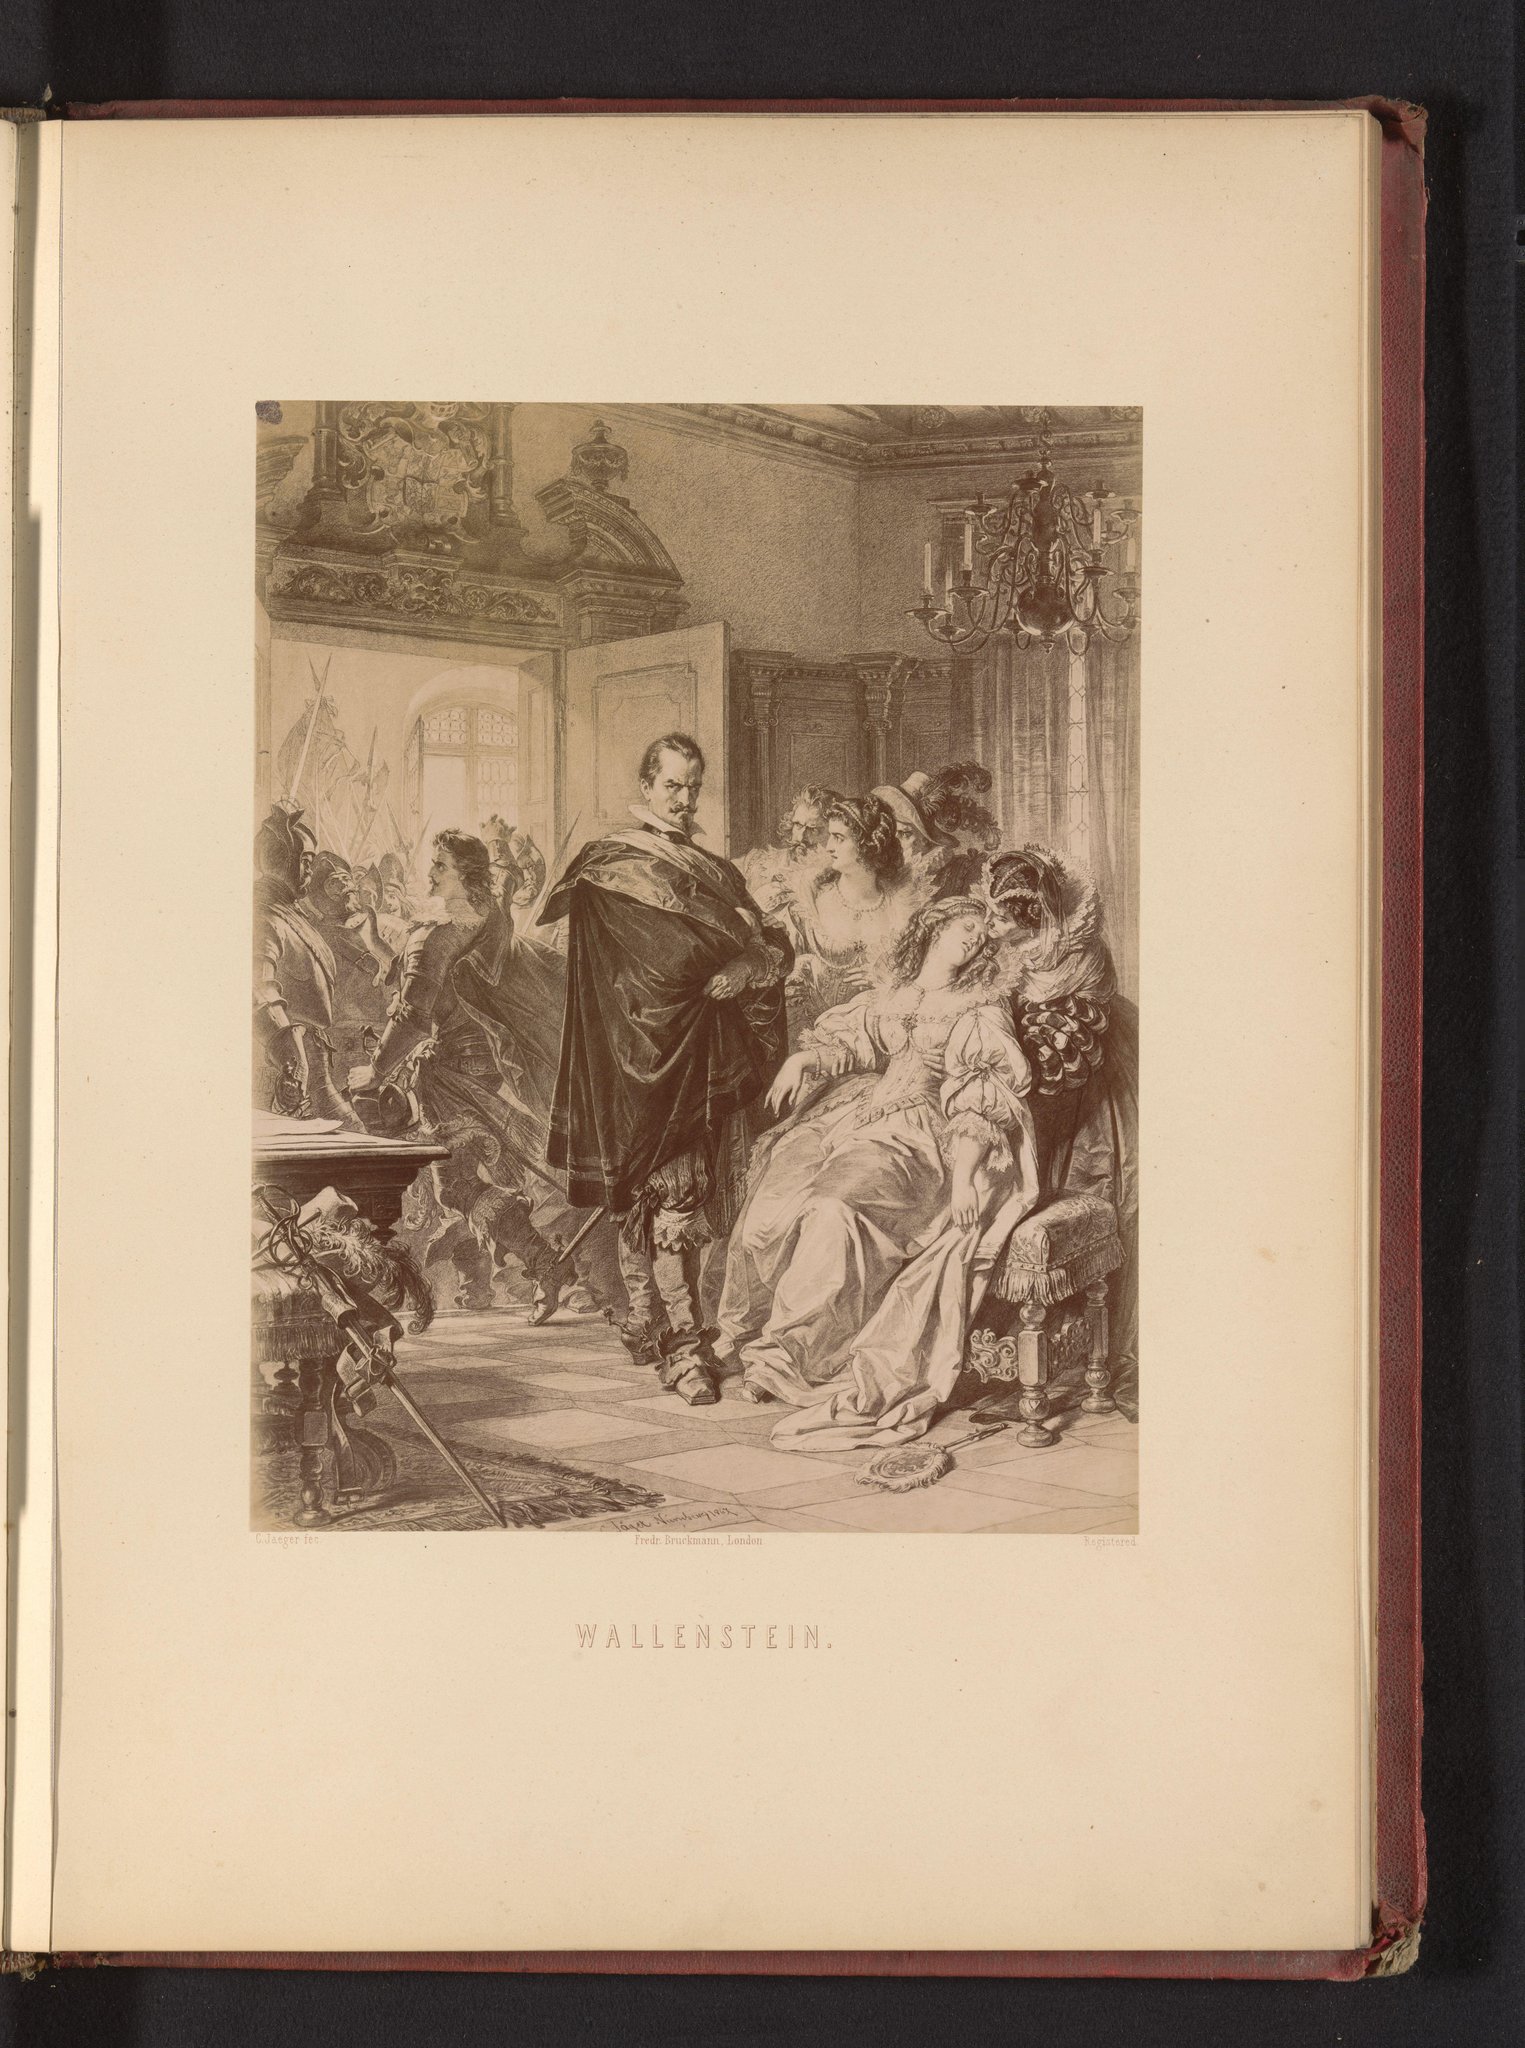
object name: page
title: Fotoreproductie van een tekening van een scene uit de Wallenstein trilogie van Friedrich Schiller, door Carl Jaeger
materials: photographic support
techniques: albumen print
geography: london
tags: fighting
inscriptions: inscription: ‘Registered.’